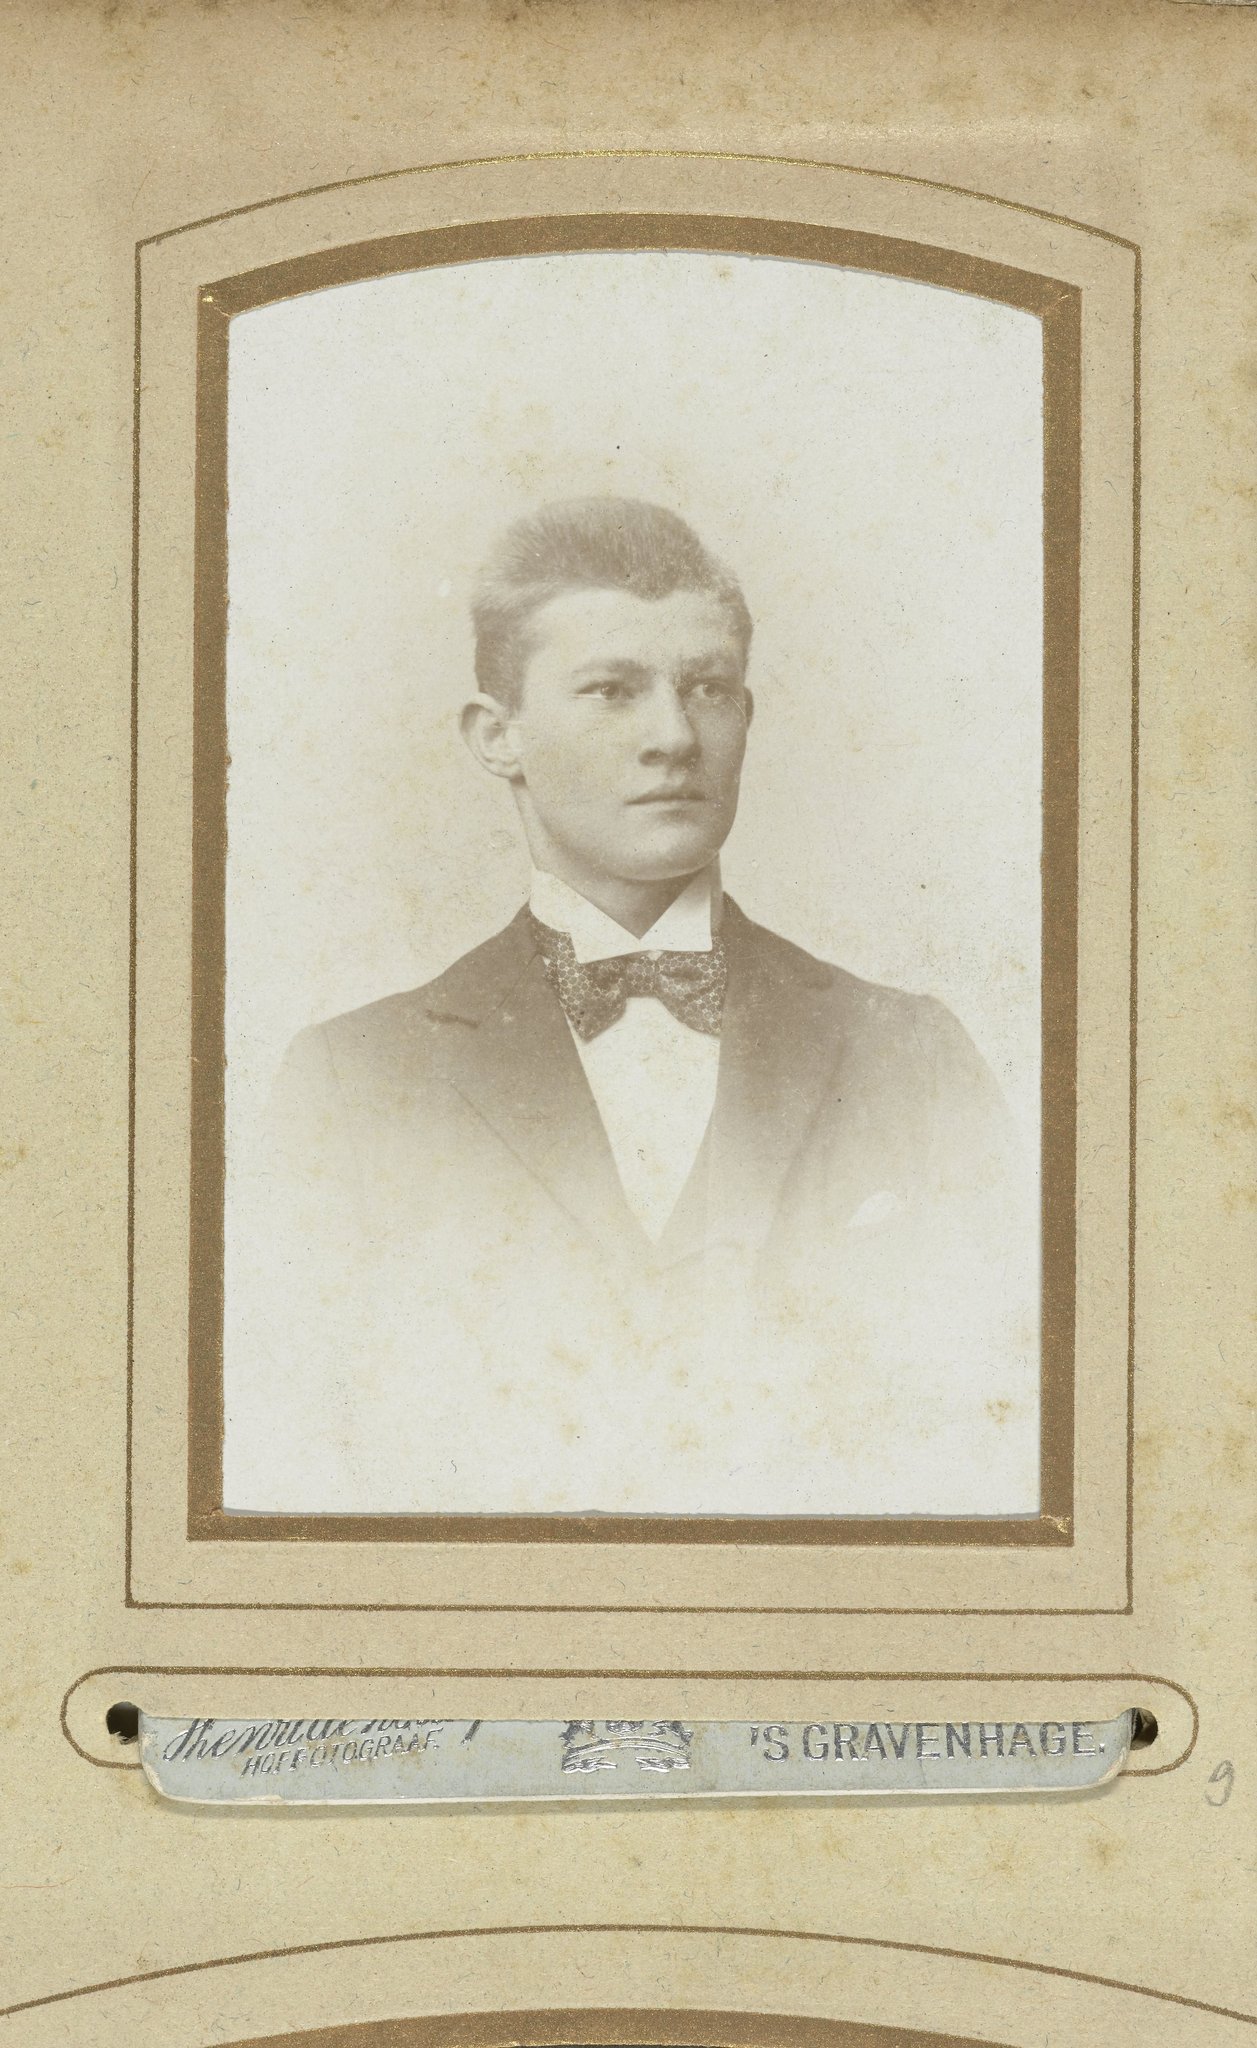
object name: carte de visite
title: Portret van Dolph Abendanon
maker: henri de louw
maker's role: fotograaf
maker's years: 1851-1944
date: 1882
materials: paper, photographic support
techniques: photography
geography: the hague